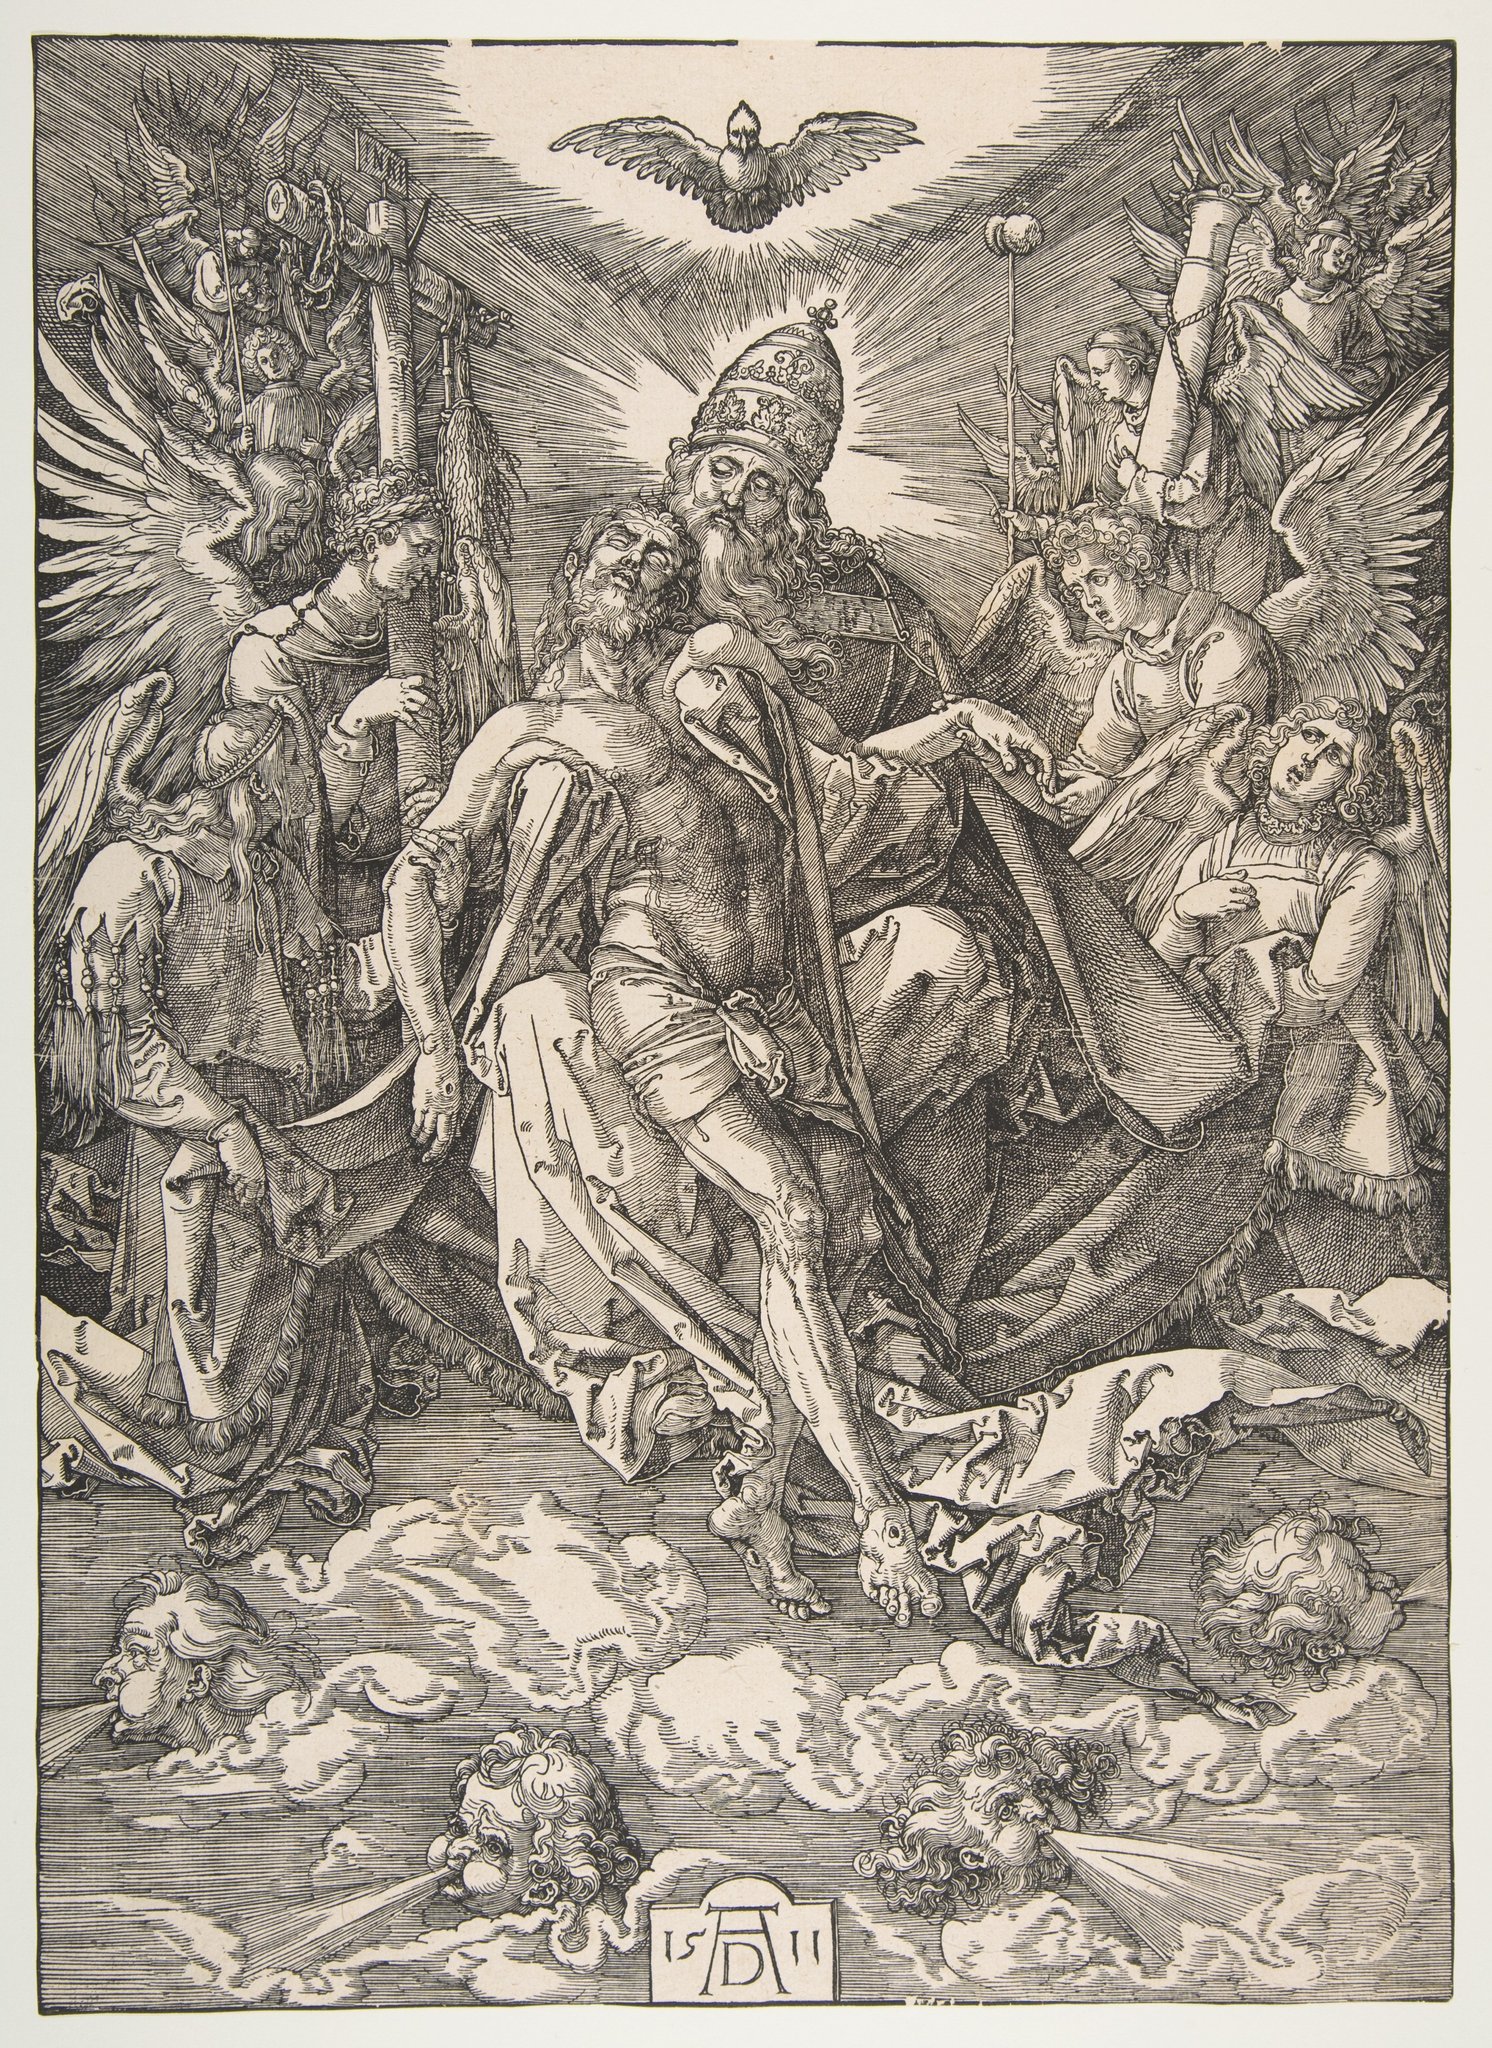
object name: print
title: The Holy Trinity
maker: albrecht dürer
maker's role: artist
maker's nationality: german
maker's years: 1471-1528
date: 1511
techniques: woodcut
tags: men,angels,christ,cross